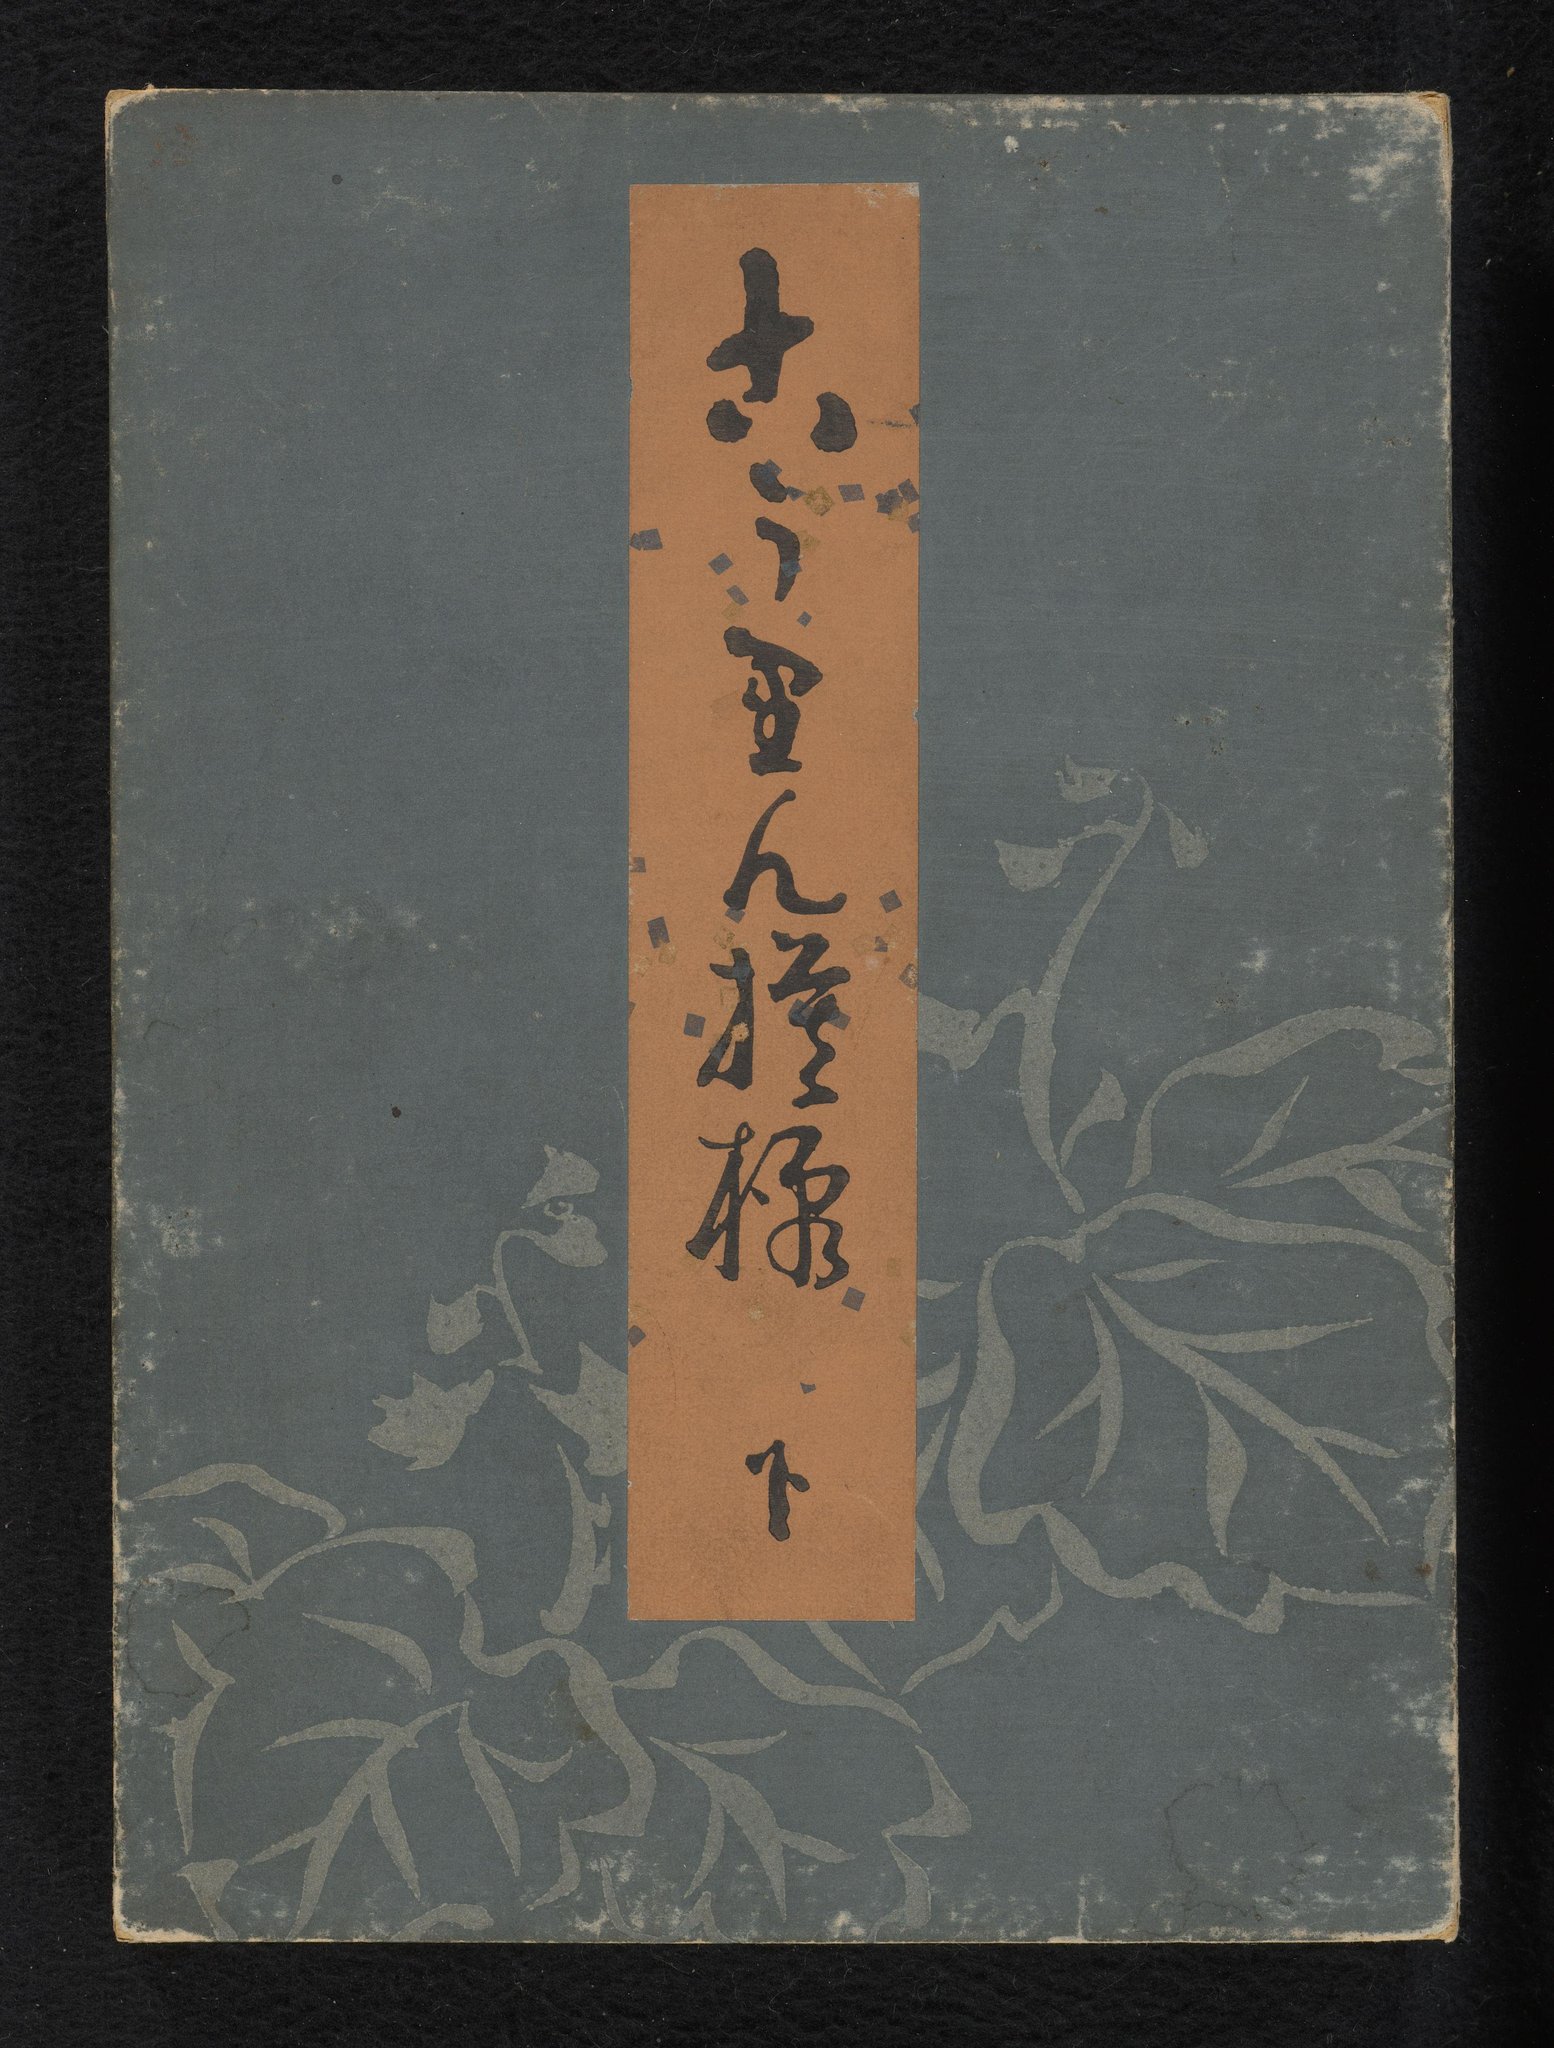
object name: book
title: Designs after Kôrin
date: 1907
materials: paper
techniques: woodcut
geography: japan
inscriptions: date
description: Leperello album met blauwe kaft waarop een motief van gebladerte, bruin titel cartouch met handgeschreven titel; 13 dubbele pagina's met kleurenhoutsnedes in neo-rinpa stijl.